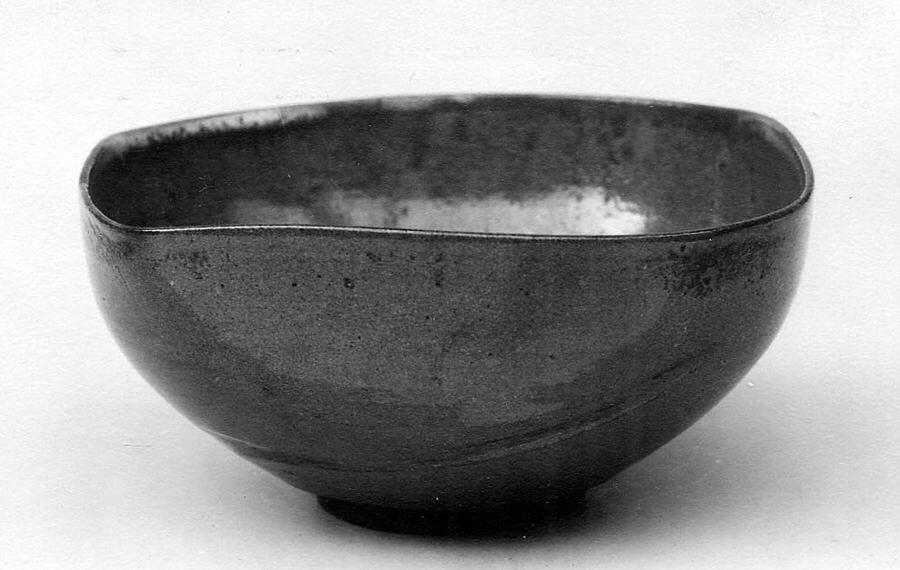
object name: teabowl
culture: japanese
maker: setosuke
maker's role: artist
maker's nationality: japanese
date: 1860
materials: clay, glaze